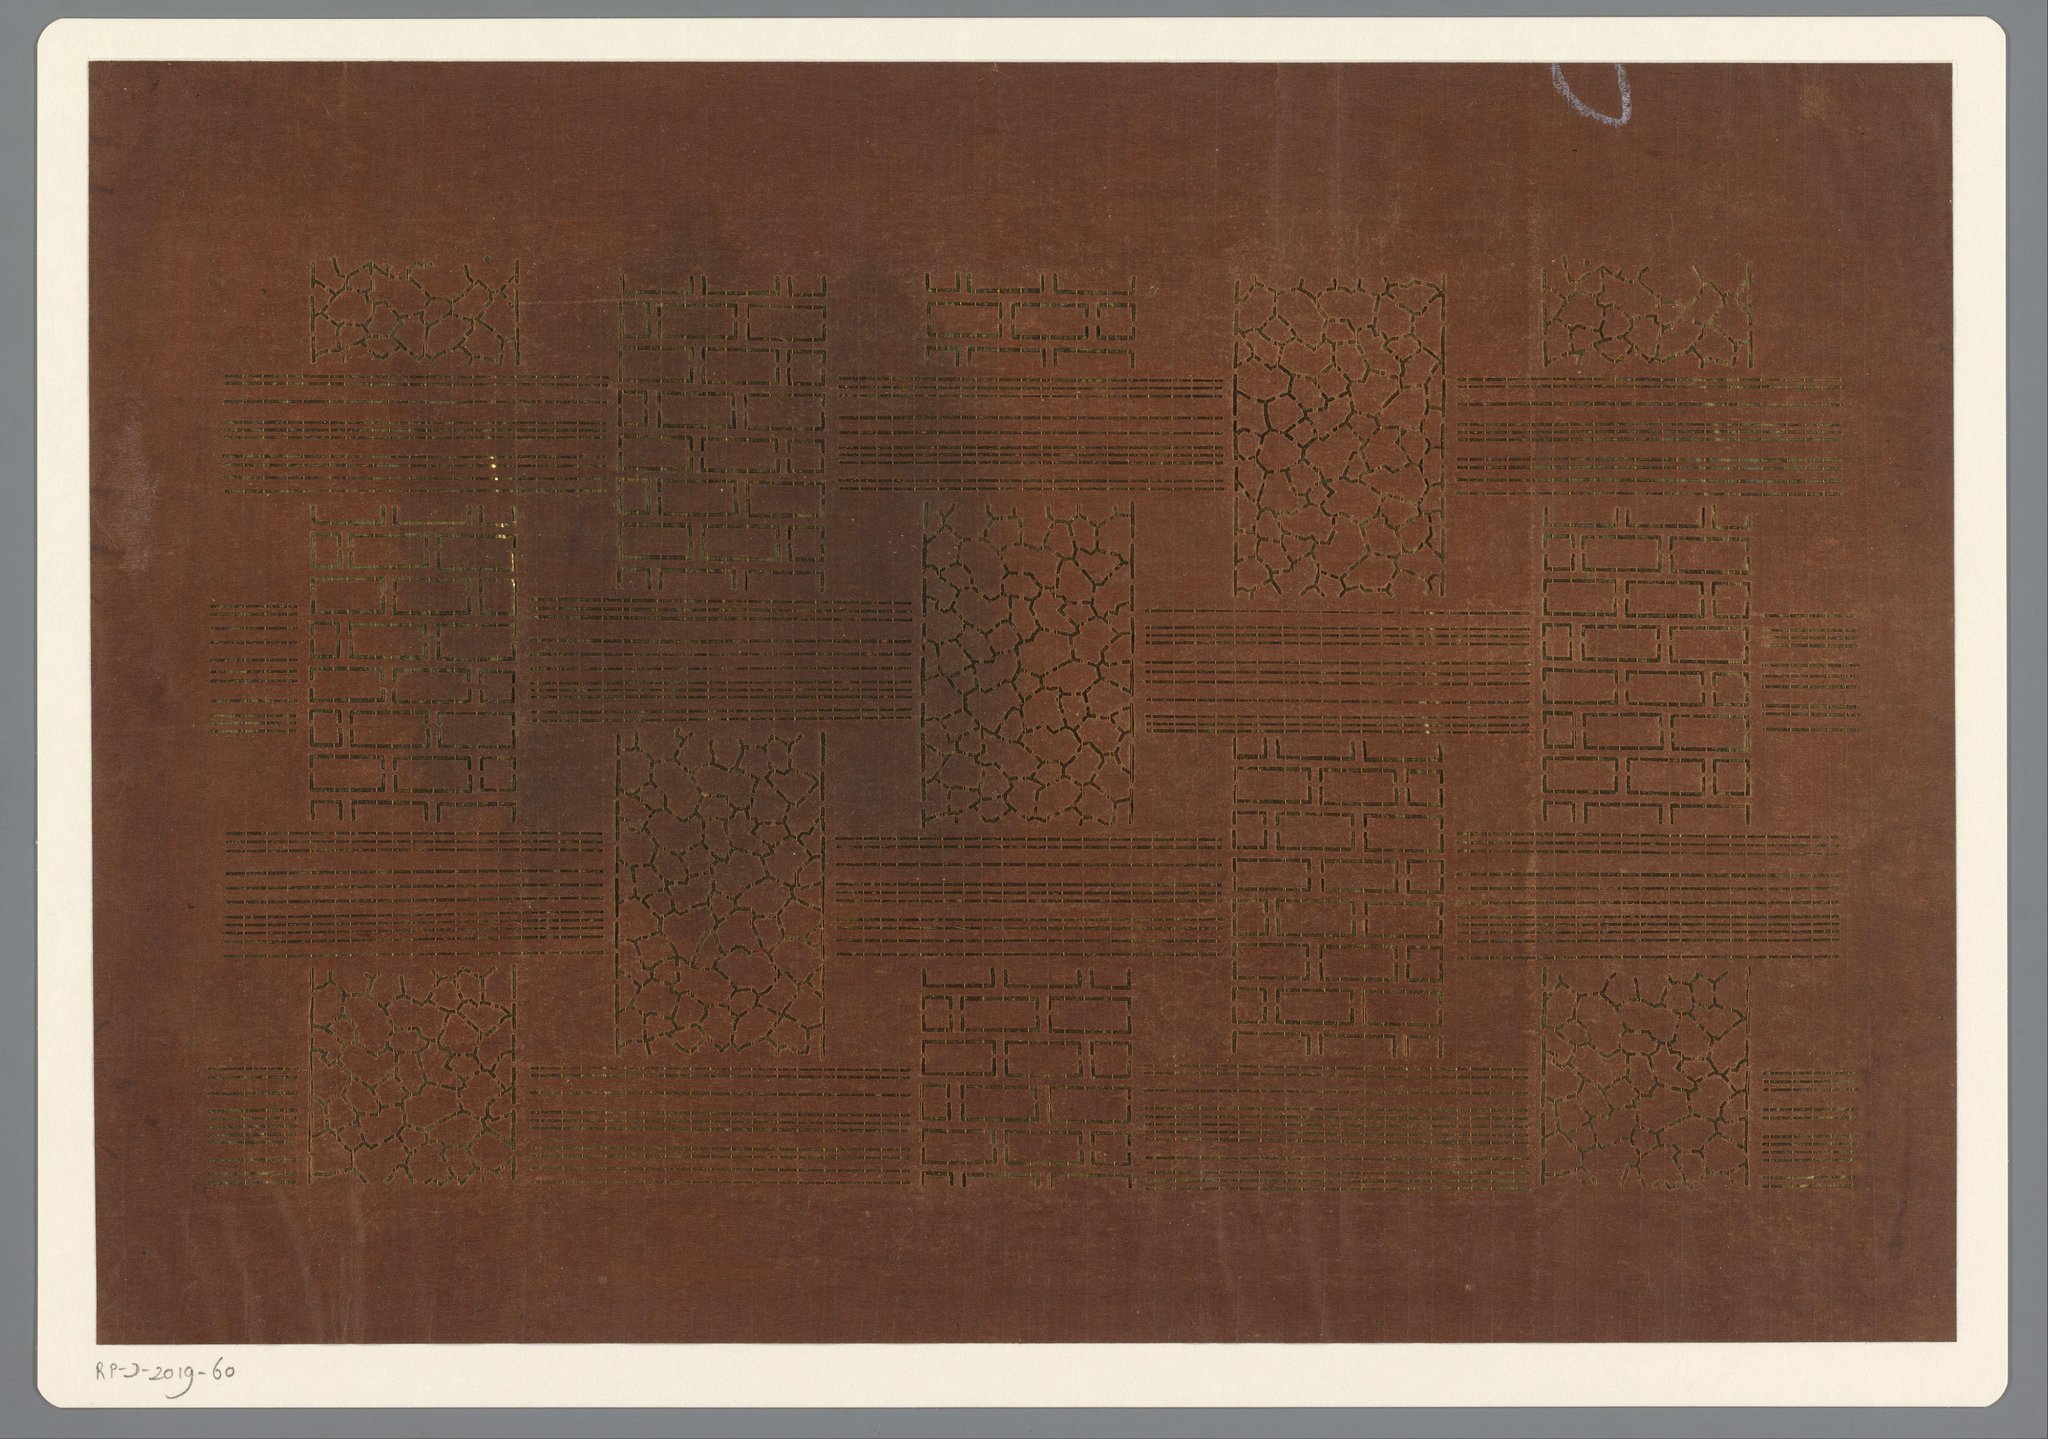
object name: katagami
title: Sjabloon met blokken en lijnen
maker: Anonymous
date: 1800-1909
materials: paper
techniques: cutting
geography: japan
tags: ornament ~ geometric motifs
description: Japanse sjabloon (katagami) met een patroon verticale blokken met verschillende steenstructuren en horizontale lijnen. Achter het sjabloon een vel goudpapier.